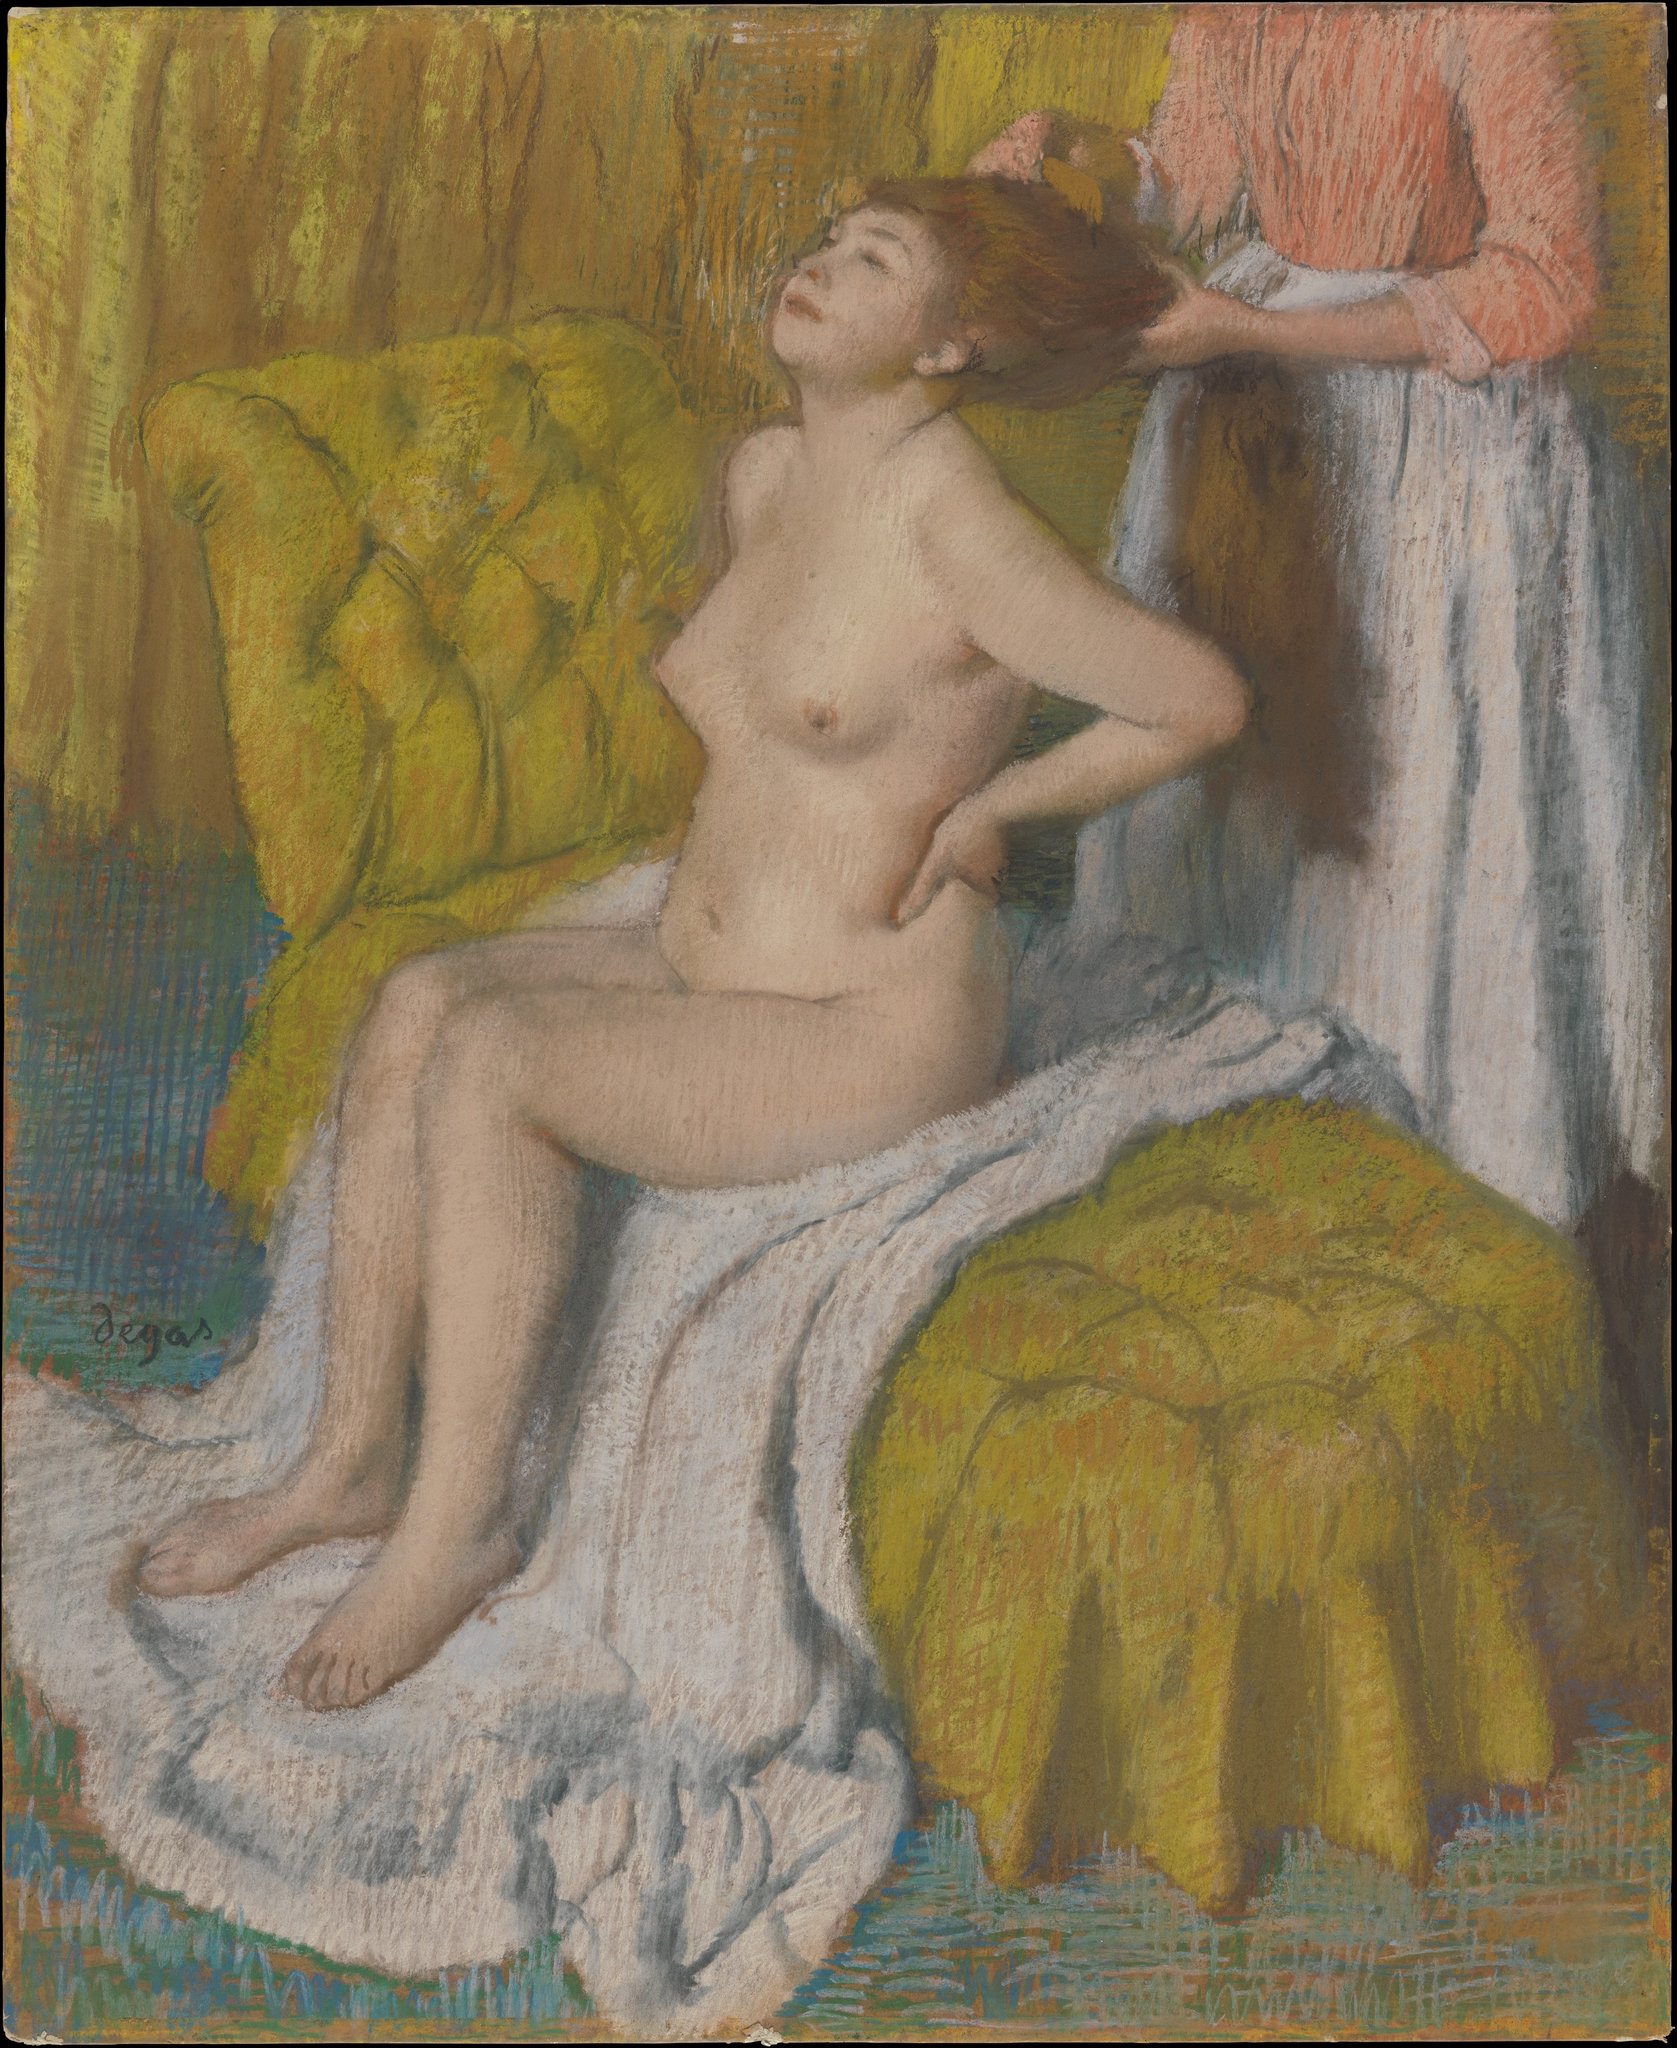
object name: drawing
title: Woman Having Her Hair Combed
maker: edgar degas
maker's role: artist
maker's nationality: french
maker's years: 1834-1917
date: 1886-1888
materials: pastel, paper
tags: women,female nudes